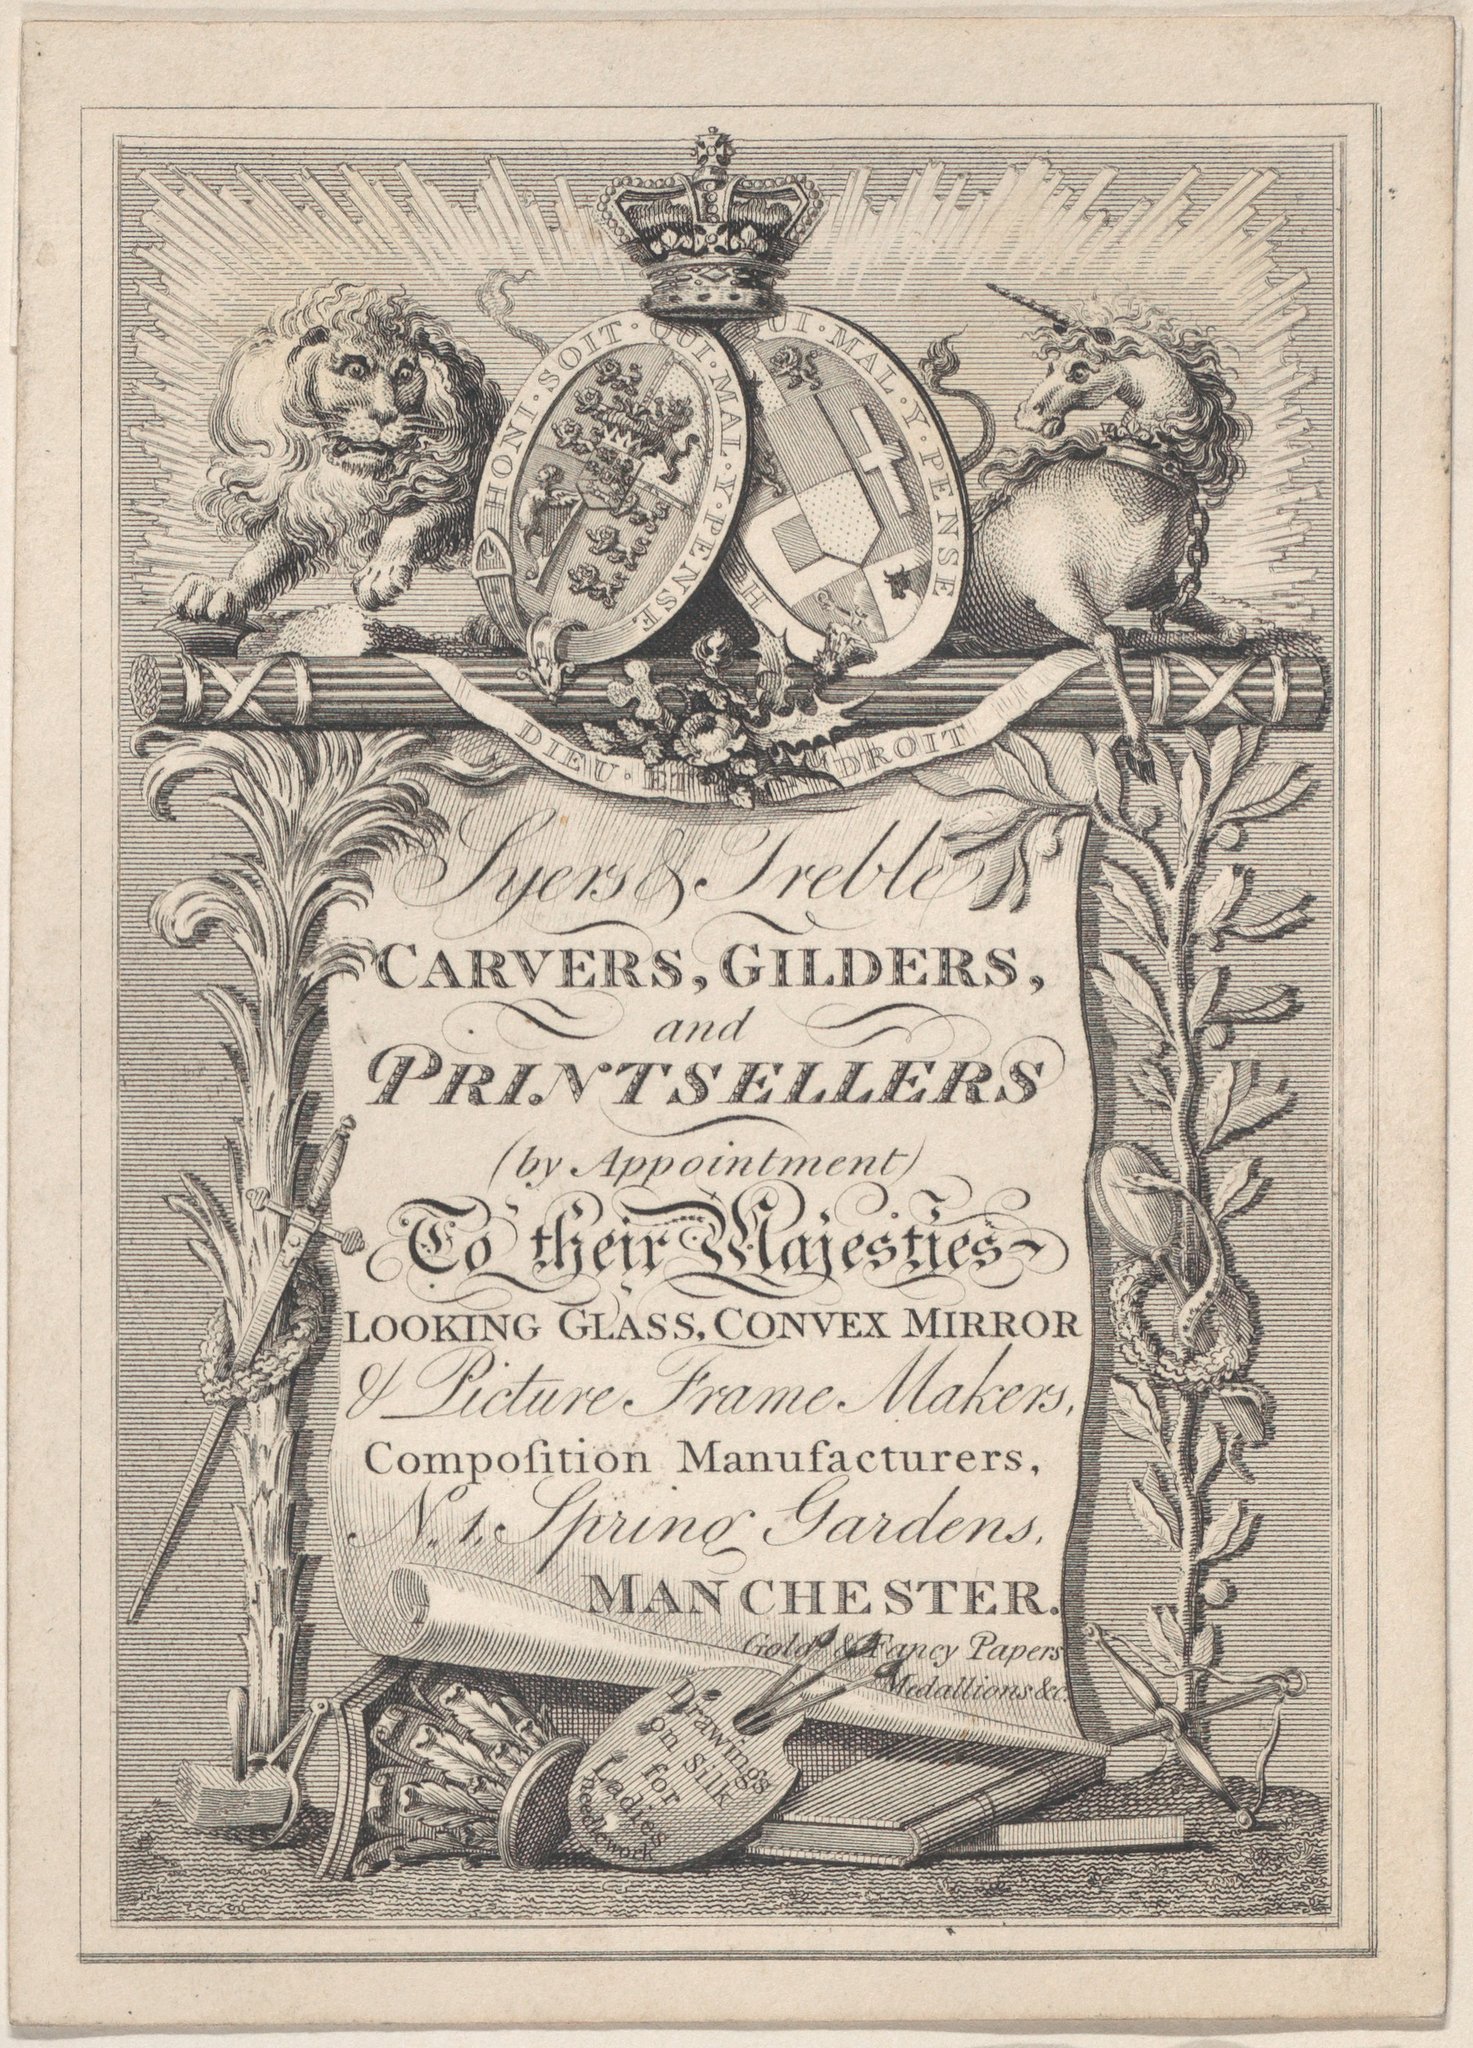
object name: print, trade card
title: Trade Card for Syers & Treble, Carvers, Gilders, and Printsellers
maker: anonymous, british, 19th century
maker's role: artist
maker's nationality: british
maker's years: 1800-1900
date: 1801-1900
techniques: engraving